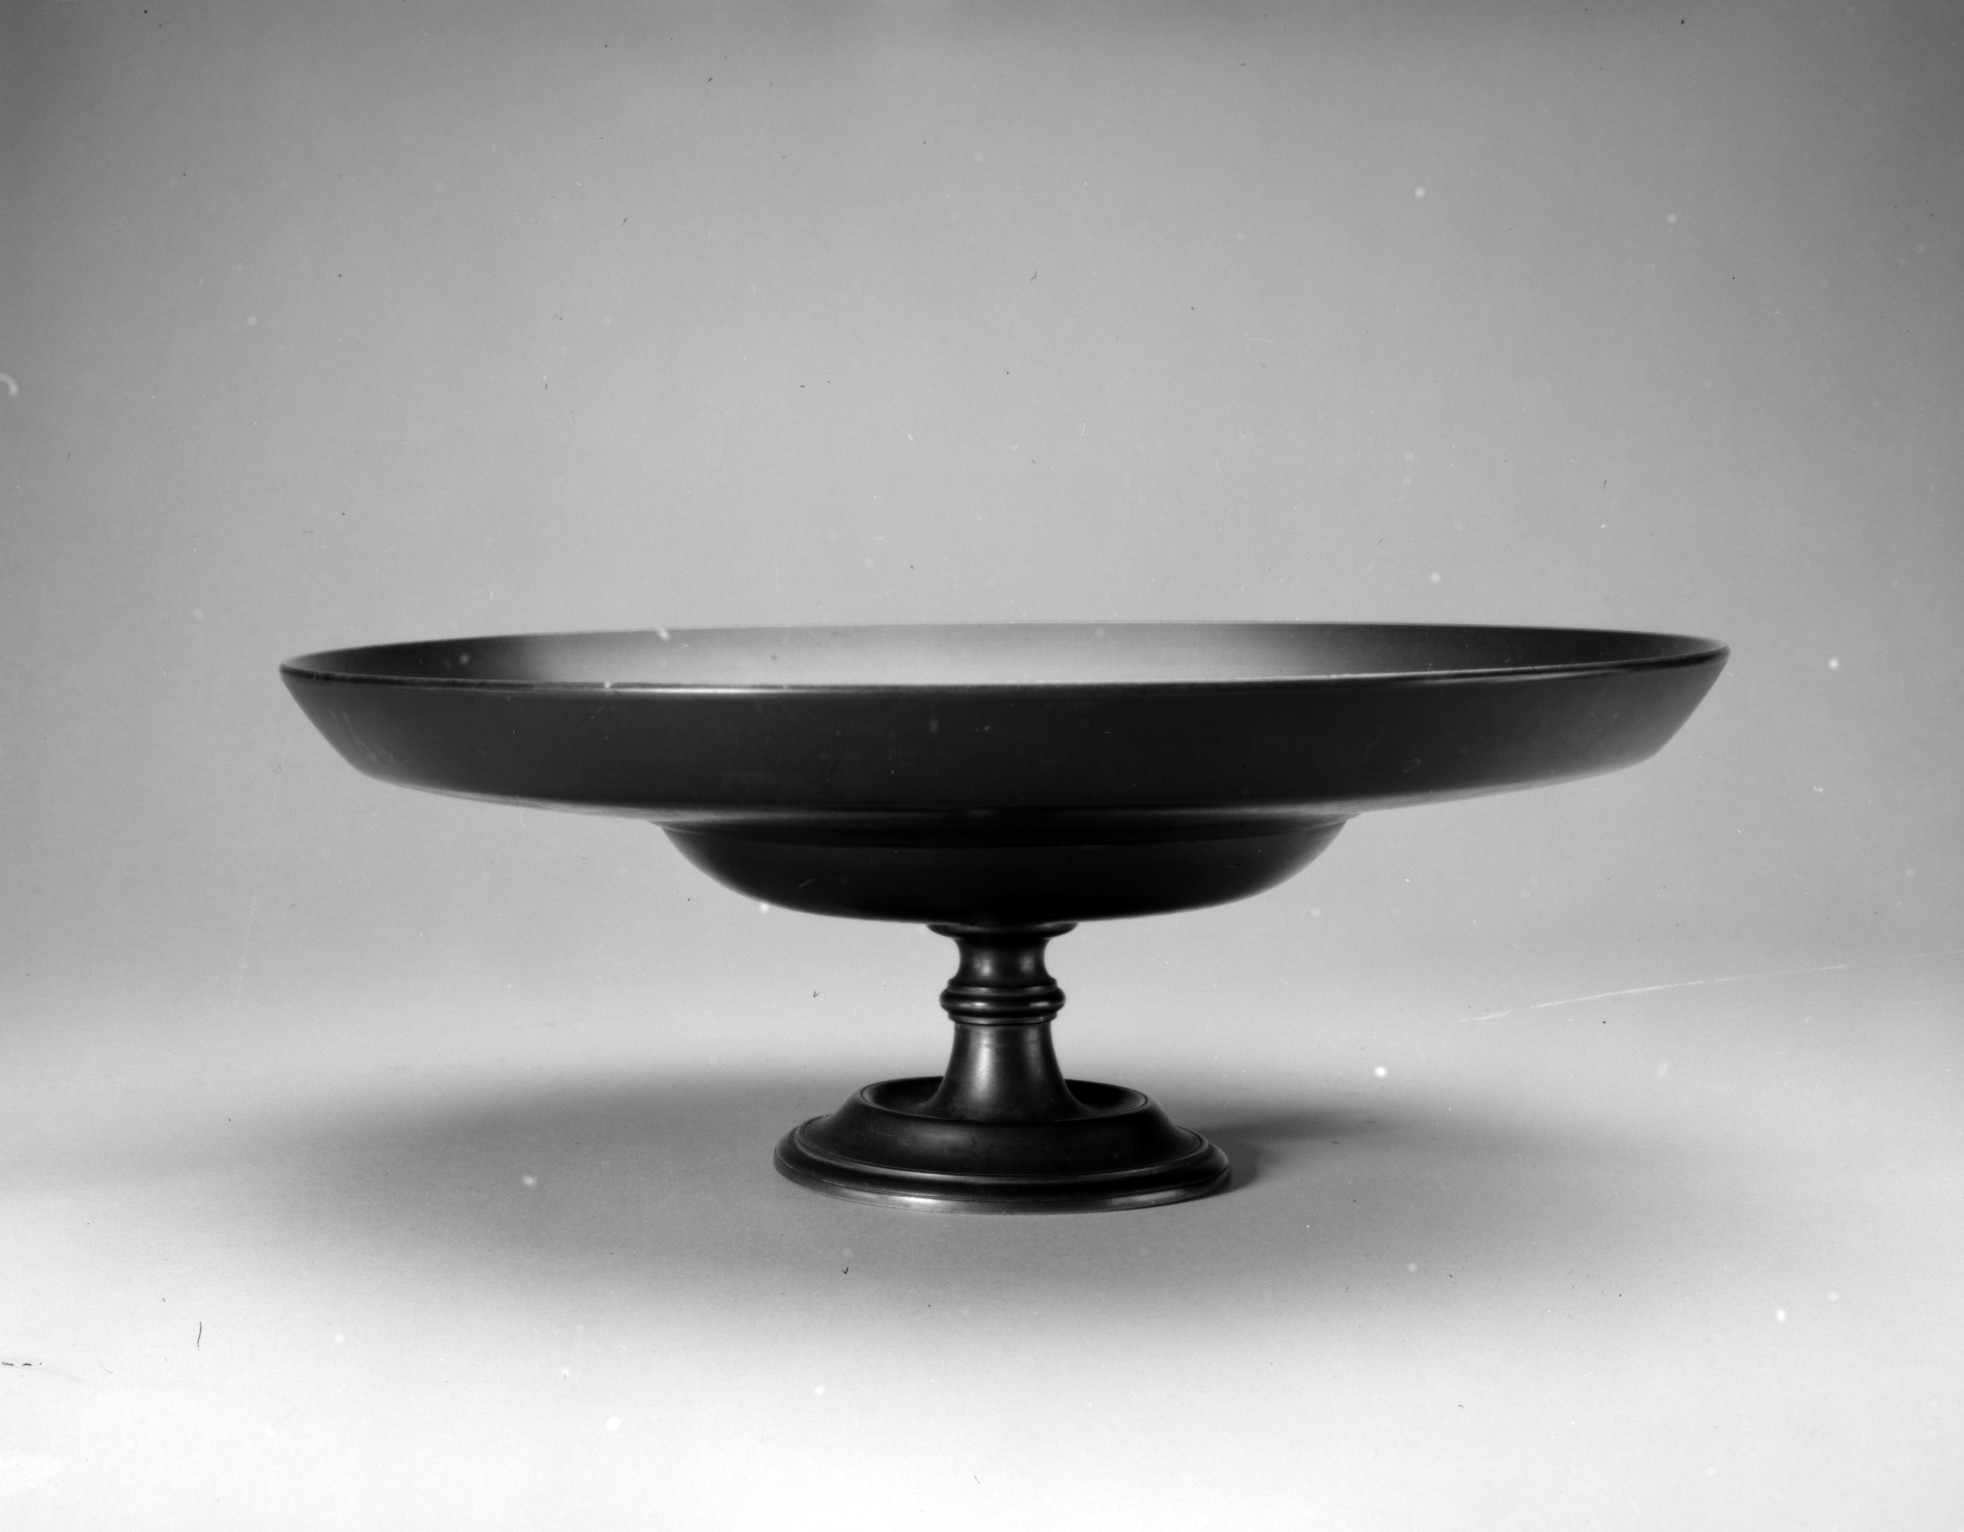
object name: tazza with medallion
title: L'Age Heureux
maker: victor peter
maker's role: artist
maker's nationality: french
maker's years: 1840-1918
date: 1900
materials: bronze